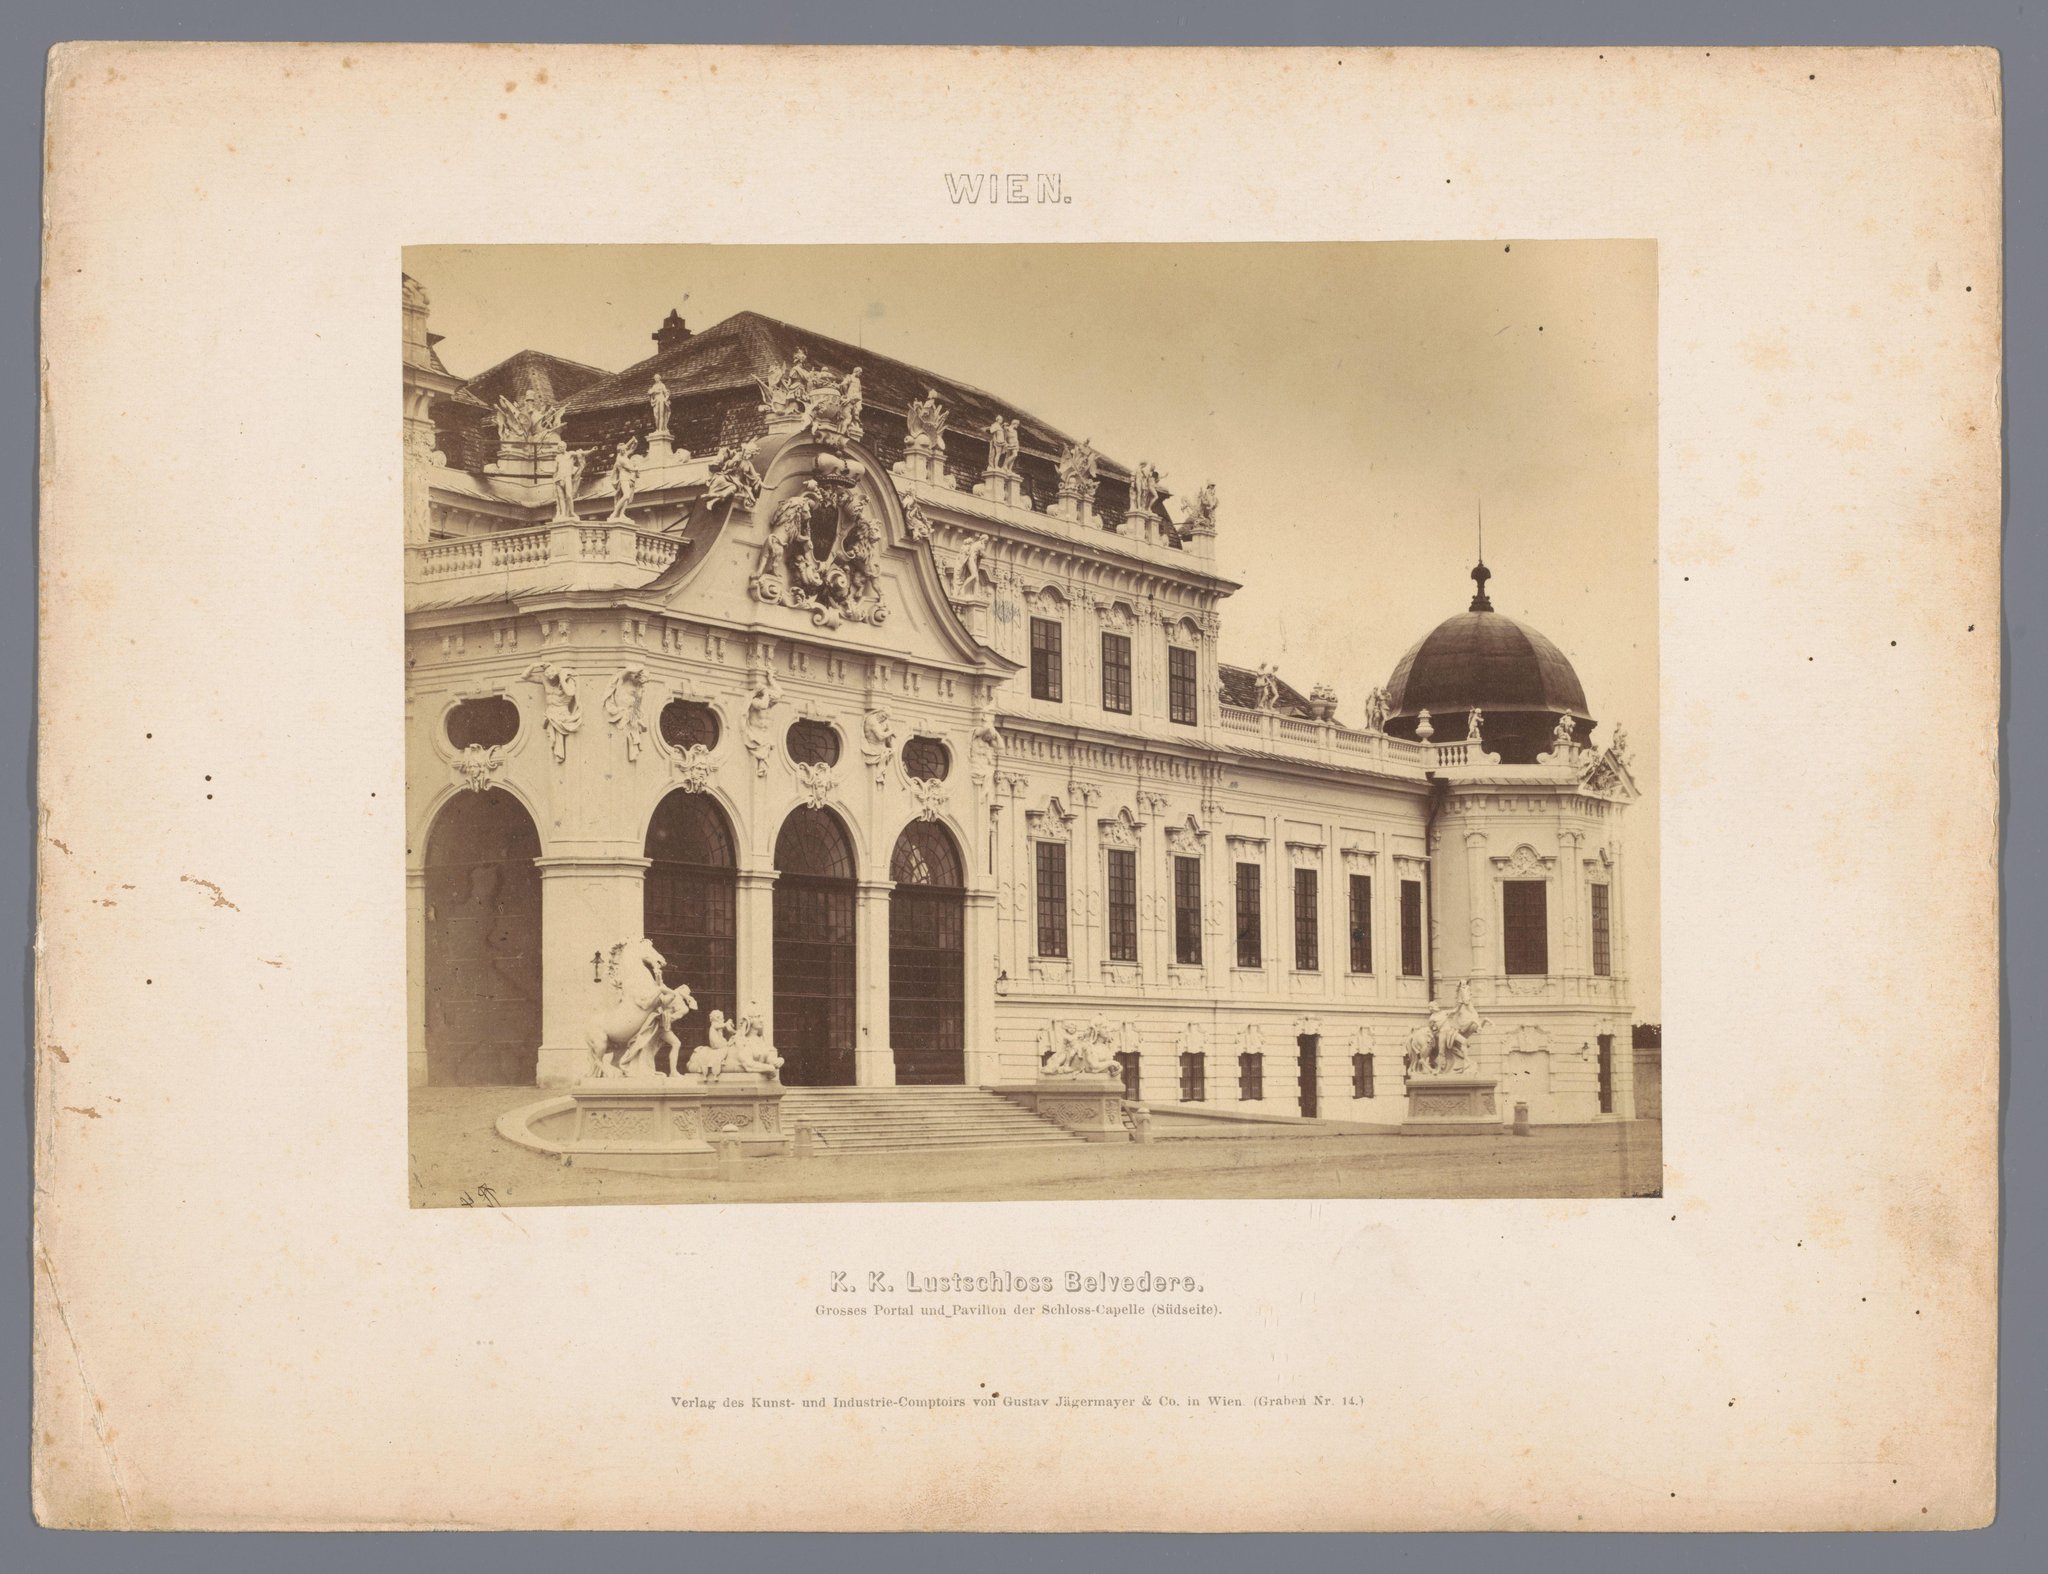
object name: photograph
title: Gezicht op Slot Belvédère in Wenen, Oostenrijk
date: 1851-1900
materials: cardboard, paper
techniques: albumen print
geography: vienna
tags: palace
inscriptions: address: ‘Wien Verlag des Kunst- und Industrie-Comptoirs von Gustav Jägermayer & Co. in Wien (Graben Nr. 14.)’, stamp: ‘RIJKS SCHOOL VOOR KUNSTNYVERHEID/ GROEP[...]’